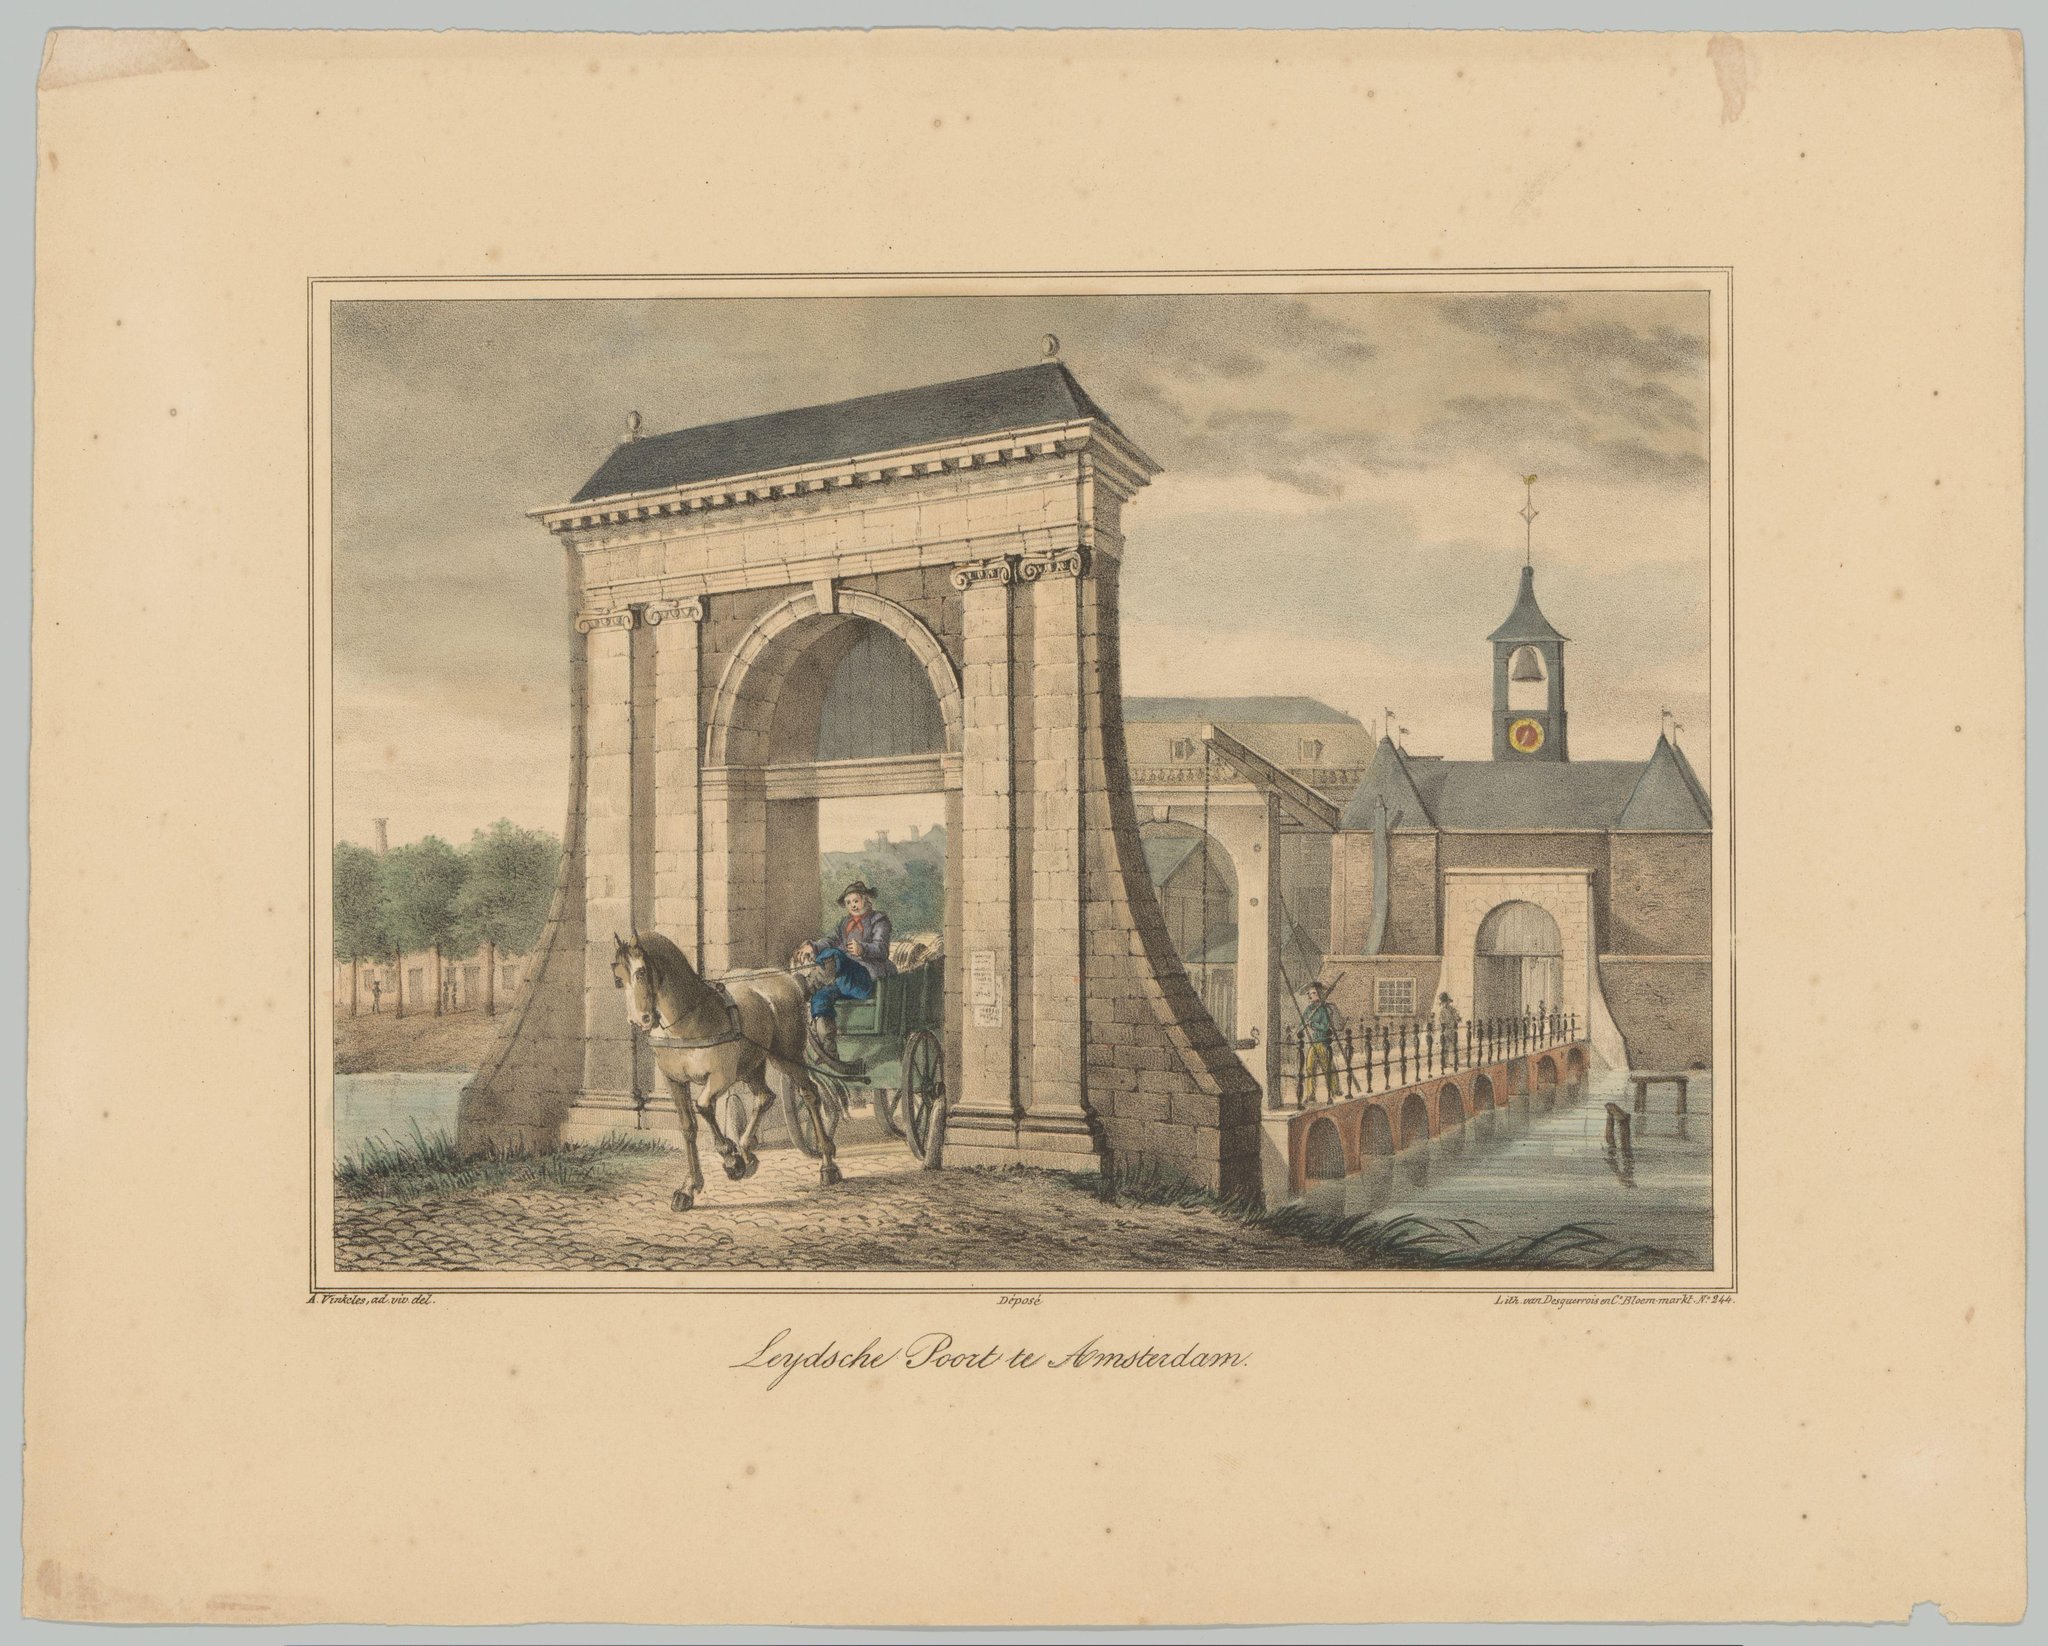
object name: print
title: Gezichten van de Zes Voornaamste Poorten der Stad Amsterdam. 1ste Cahier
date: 1828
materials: paper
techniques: hand coloring, lithograph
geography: amsterdam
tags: gate, entrance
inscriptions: collector's mark: Lugt 2228, : ‘Déposé.’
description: Onderdeel van een omslag met een serie van zes lithografieën van Amsterdamse poorten.